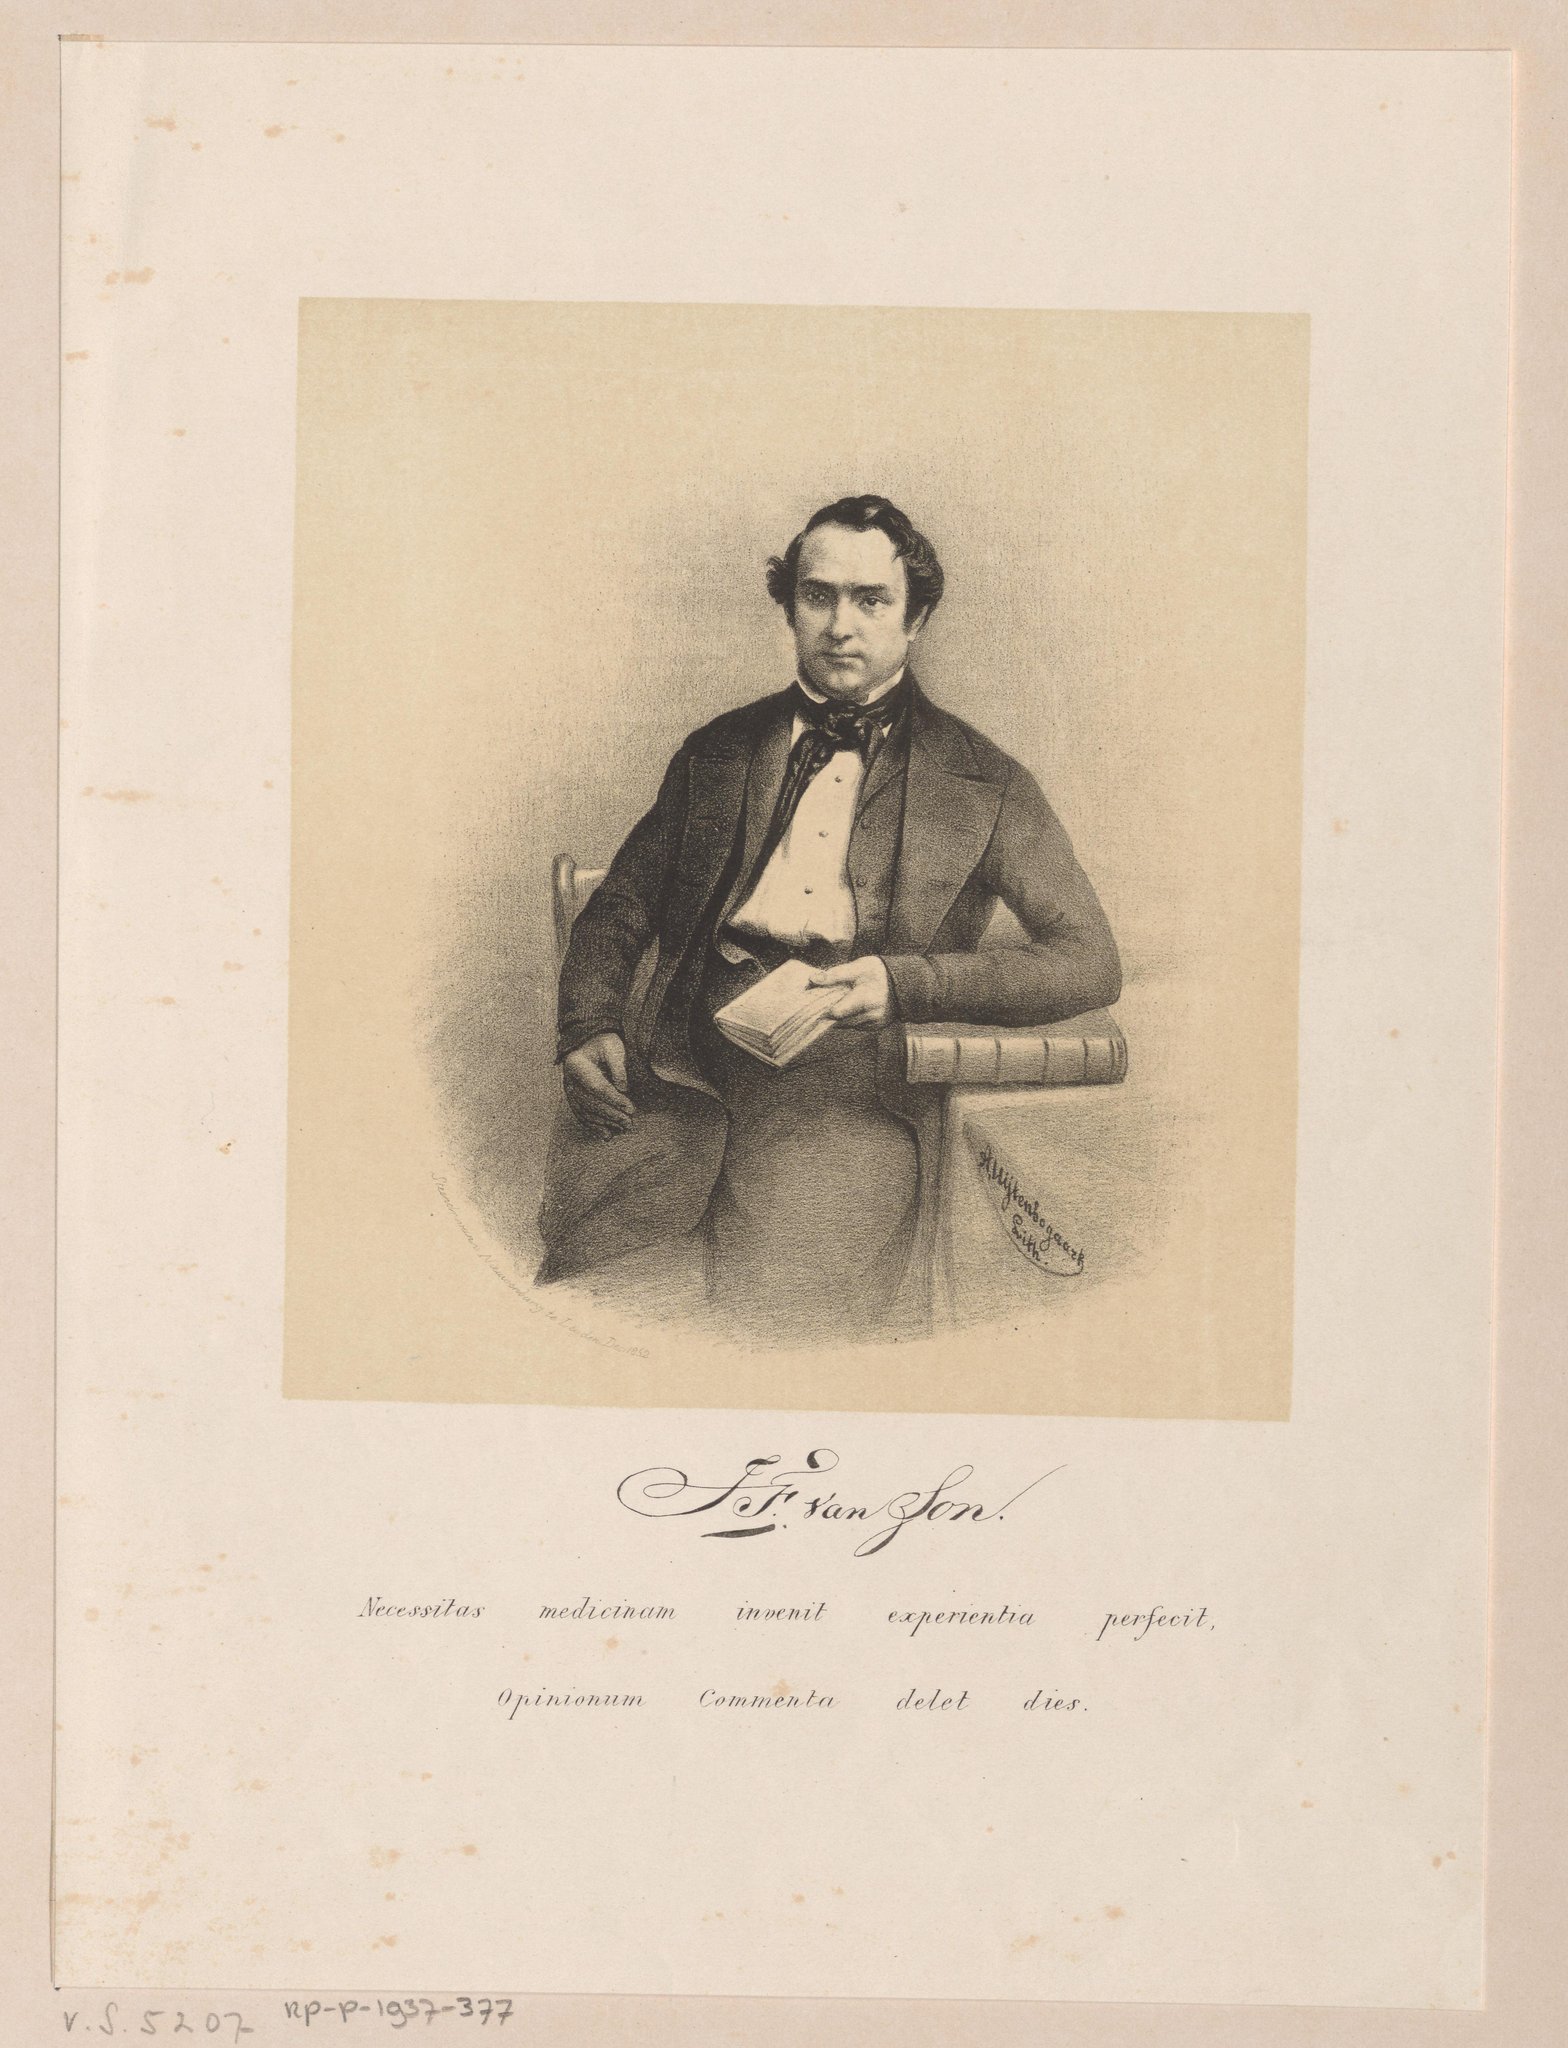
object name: print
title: Portret van J.F. van Son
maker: abraham uytenbogaart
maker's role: print maker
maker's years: 1803-1865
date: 1852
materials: paper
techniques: tone lithography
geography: leiden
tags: historical persons, physician, doctor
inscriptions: collector's mark: Lugt 2228, collector's mark: Lugt 2760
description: Met tweeregelig onderschrift in het Latijn.